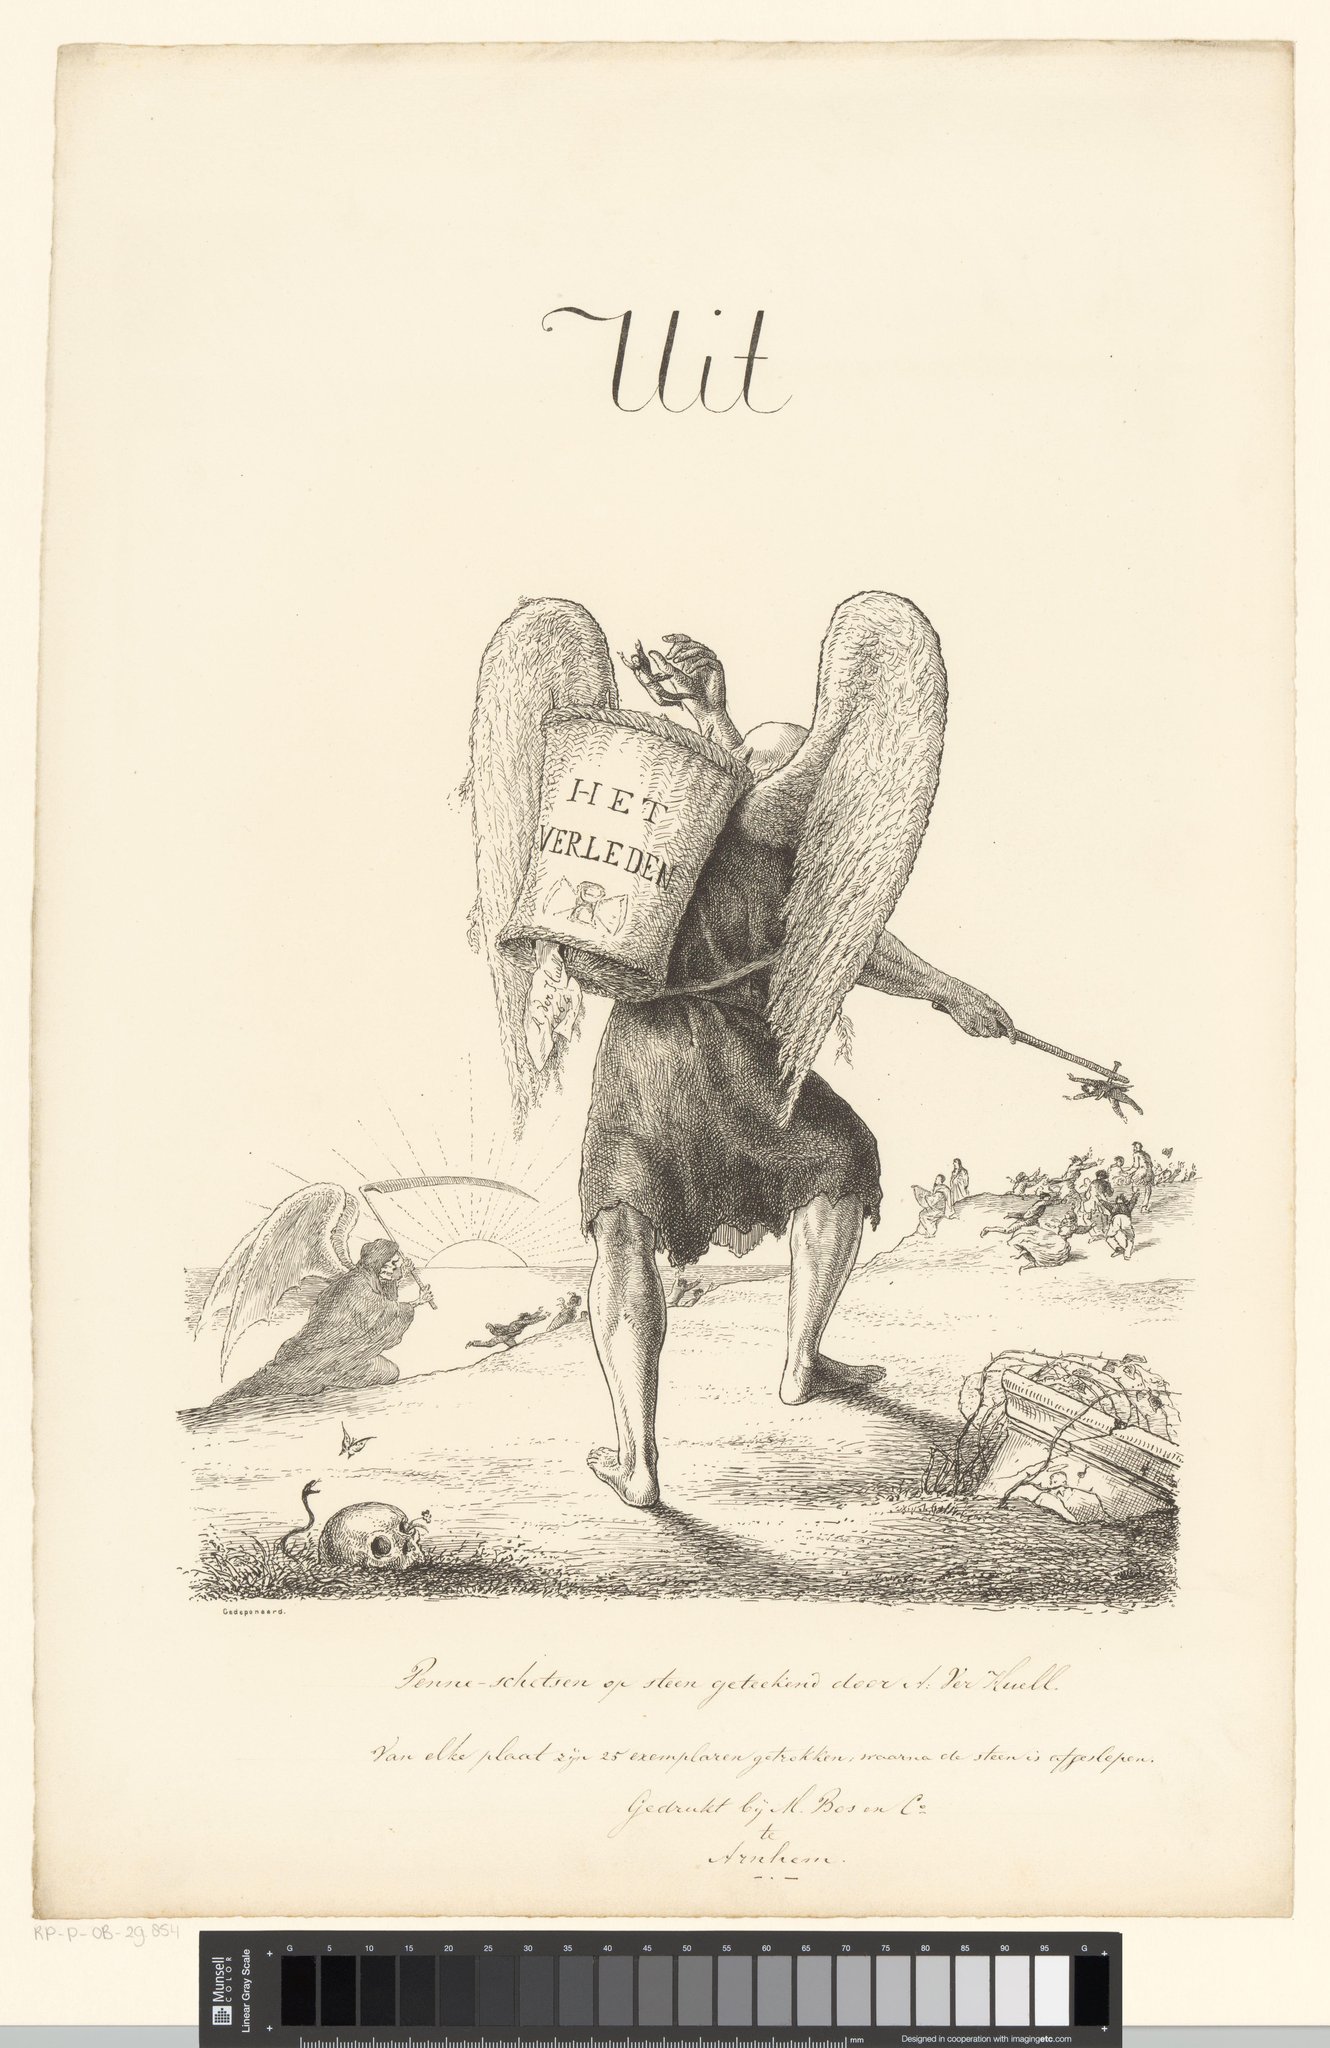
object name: print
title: Uit het verleden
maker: alexander ver huell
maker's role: draughtsman, print maker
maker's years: 1822-1897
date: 1864-1866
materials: paper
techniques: lithograph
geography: arnhem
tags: father time, man with wings and scythe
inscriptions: : ‘Gedeponeerd.’, collector's mark: Lugt 2228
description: Vader Tijd pakt vluchtende mensen op en stopt ze in de mand op zijn rug. Links jaagt de Dood met een zeis op de mensen.